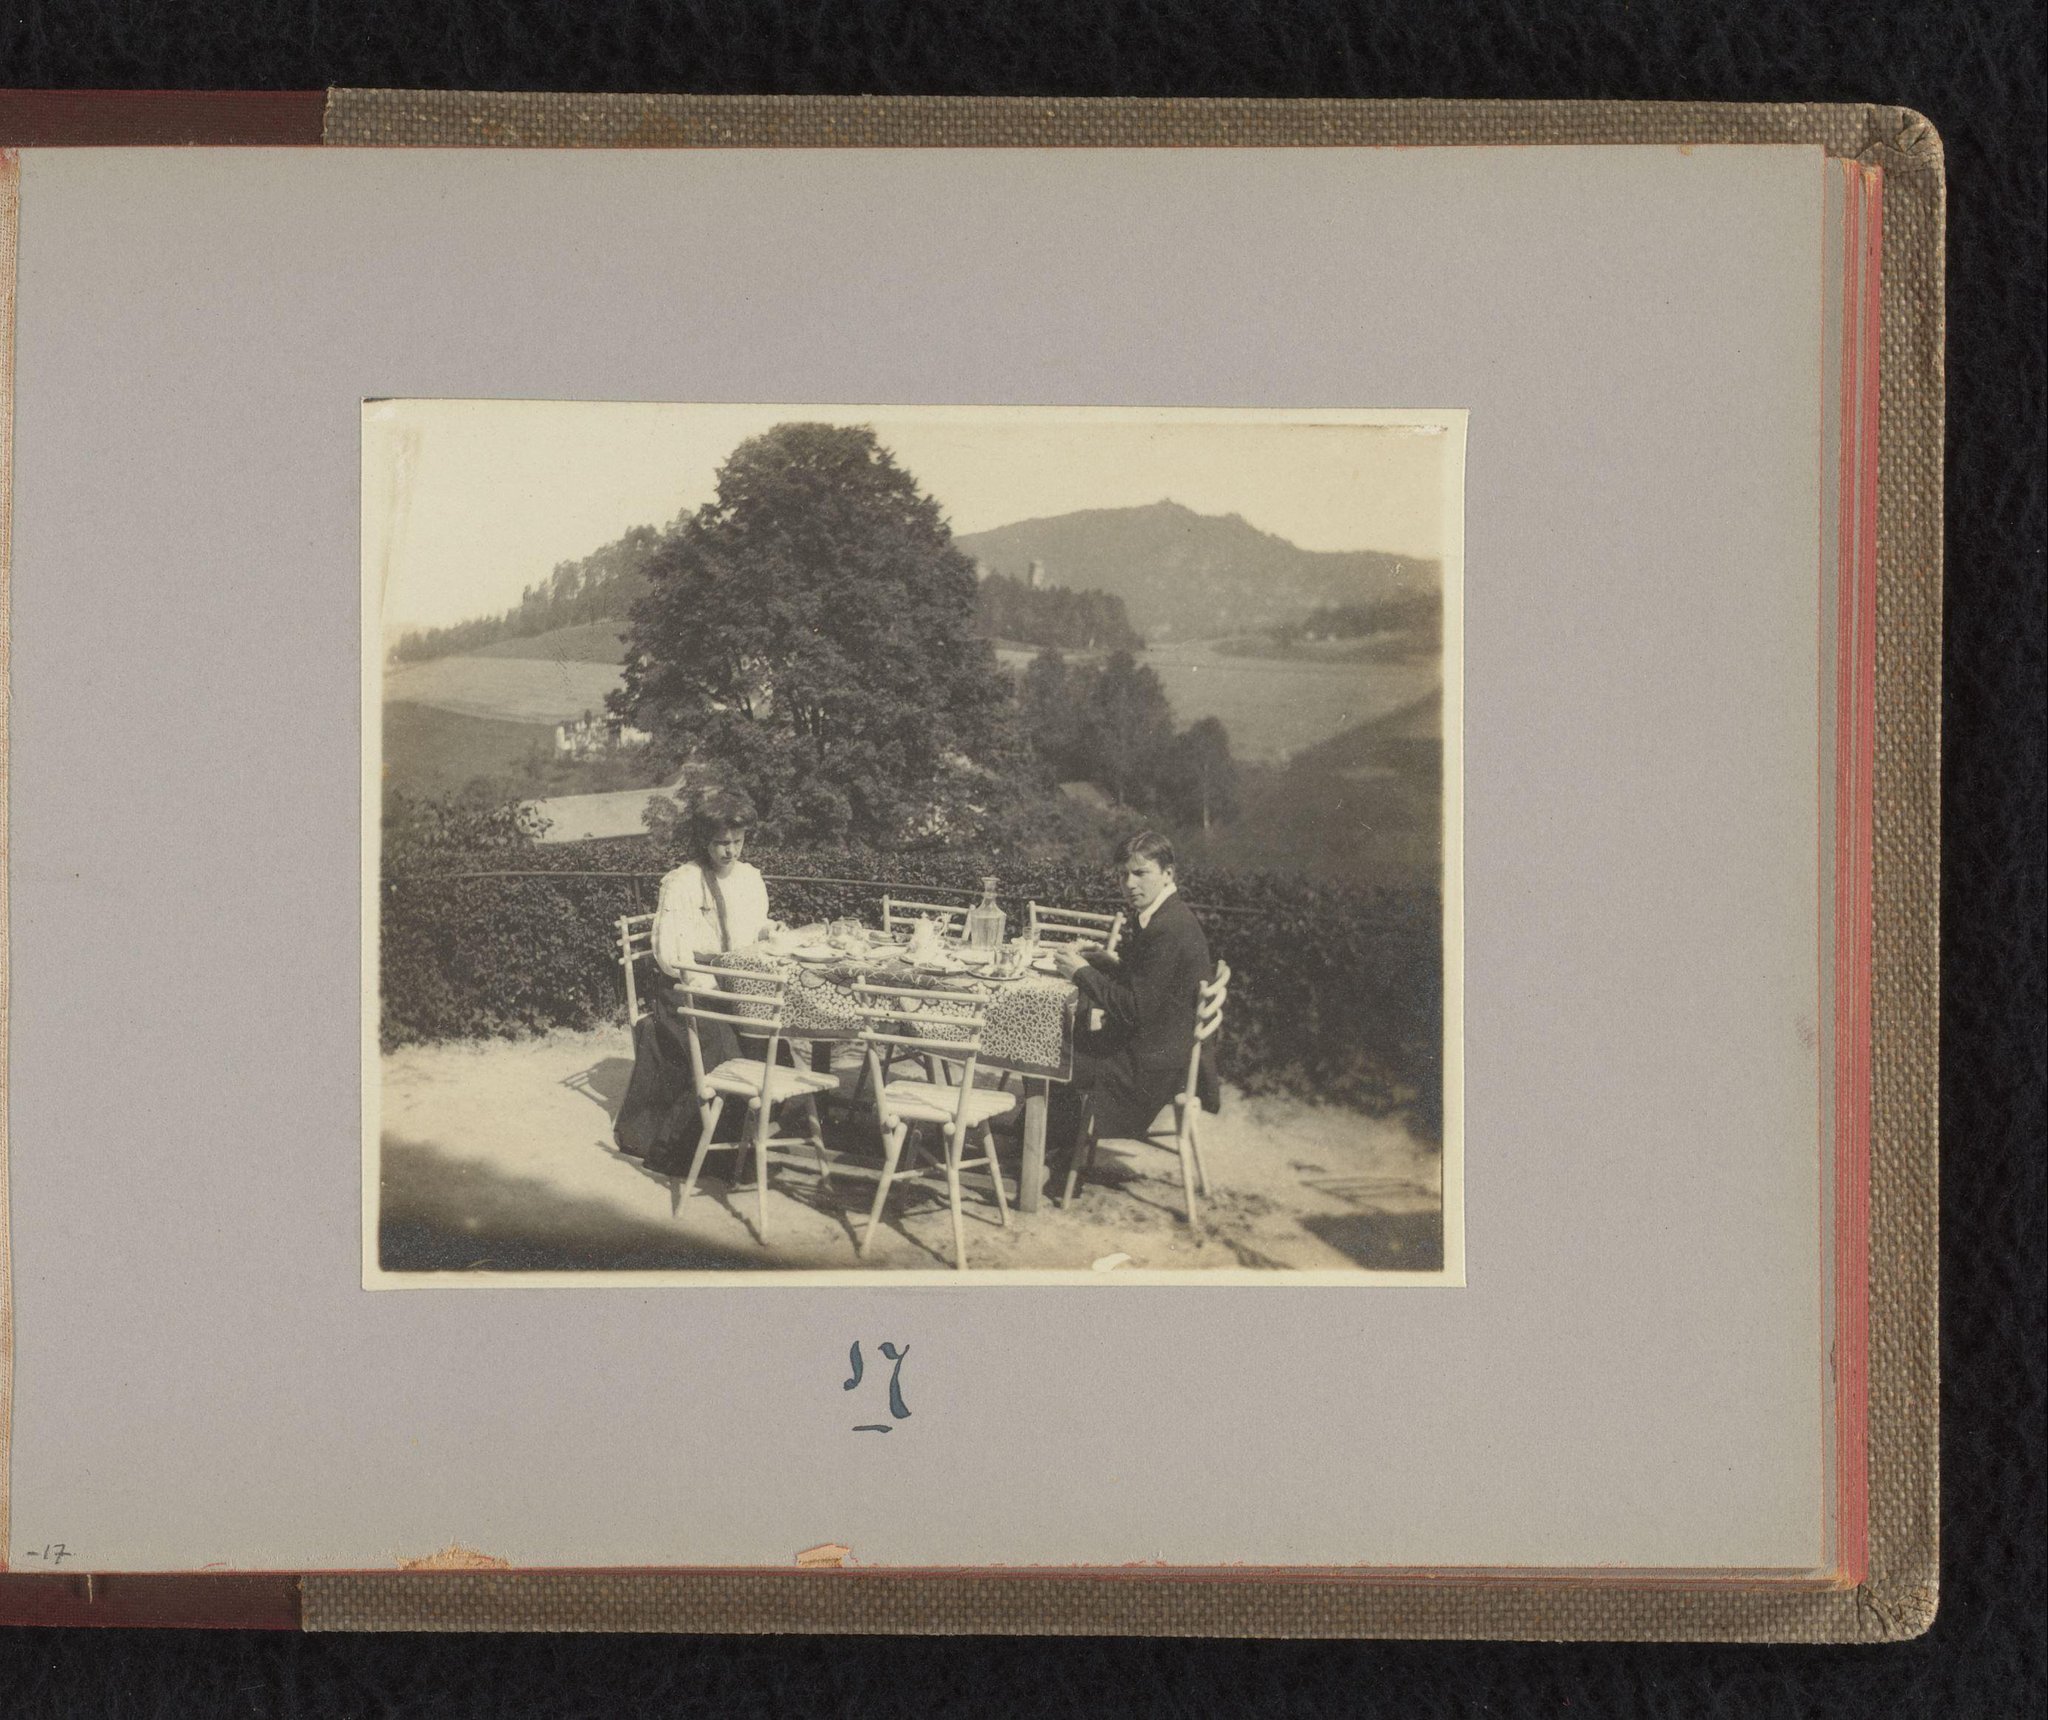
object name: photograph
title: Dittersbach - "de groote zomerdag staat open en bouwt zijn weelde over d'aarde"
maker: hermann johannes kessler (boelie)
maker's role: voetballer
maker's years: 1896-1971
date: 1910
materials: paper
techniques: gelatin silver print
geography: dittersbach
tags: johan herman kessler (jan), midday meal, lunch - cc - out of doors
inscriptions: number: ‘17’